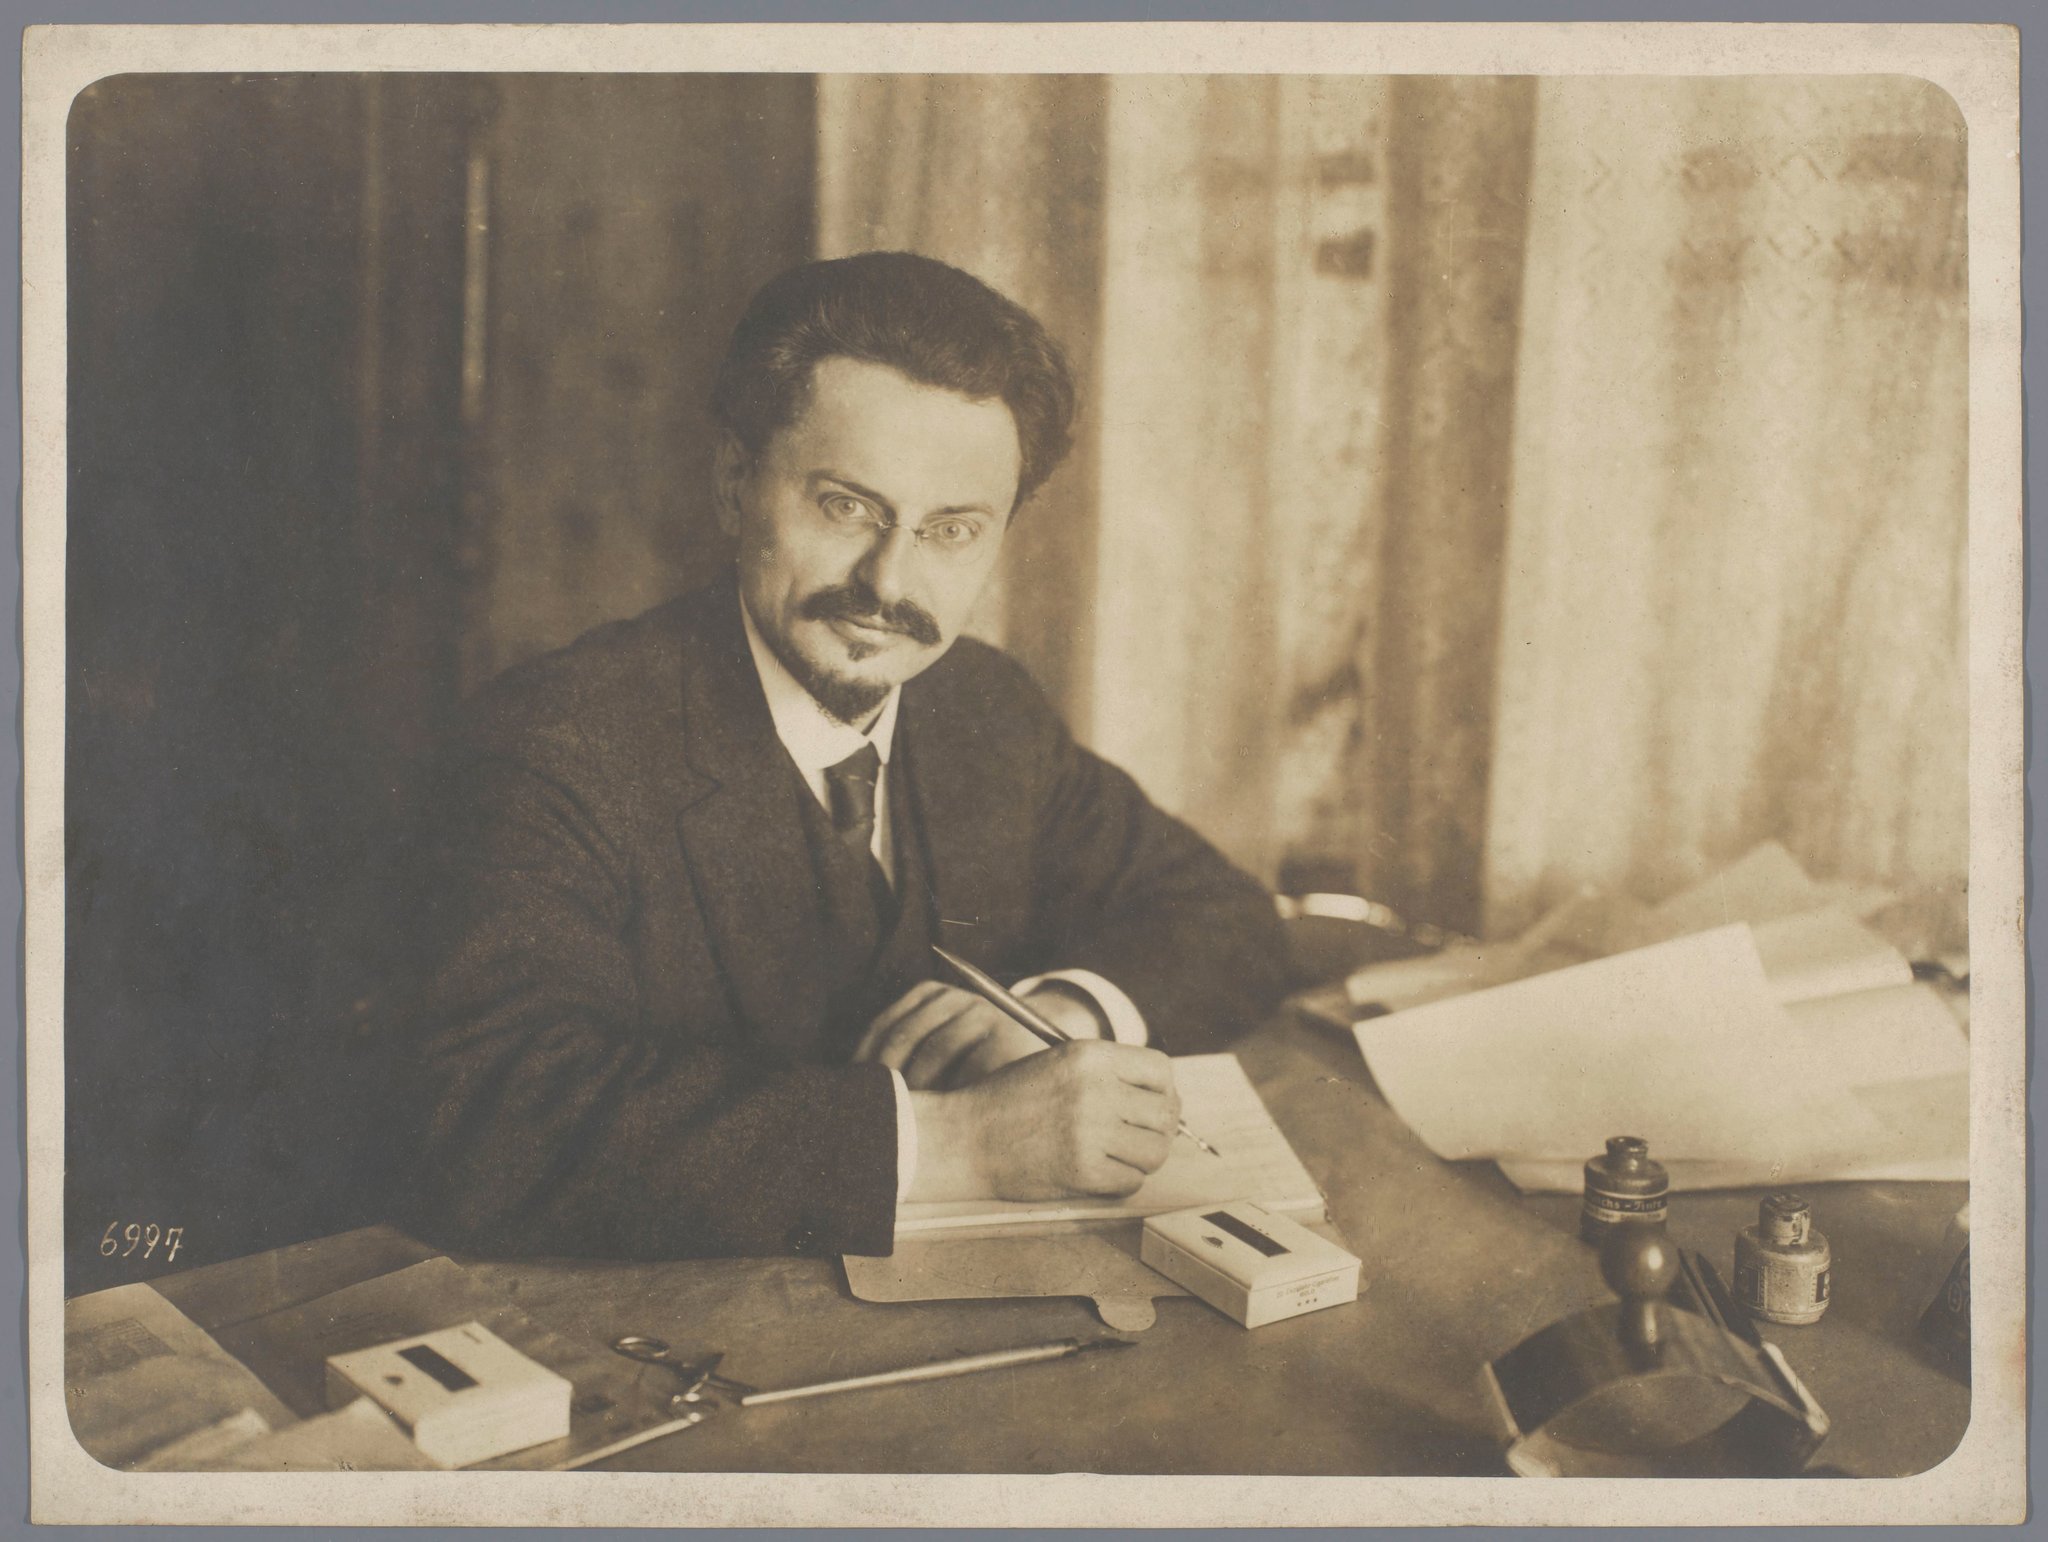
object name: photograph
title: Portret van Leon Trotski aan een bureau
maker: Anonymous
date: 1918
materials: paper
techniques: gelatin silver print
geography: brest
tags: politician, writing-table, writing-desk, historical persons, politician, e.g. party leader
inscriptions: number: ‘6997’, inscription: ‘Leon Trotski/ in Brest Litovsk maart 1918?’